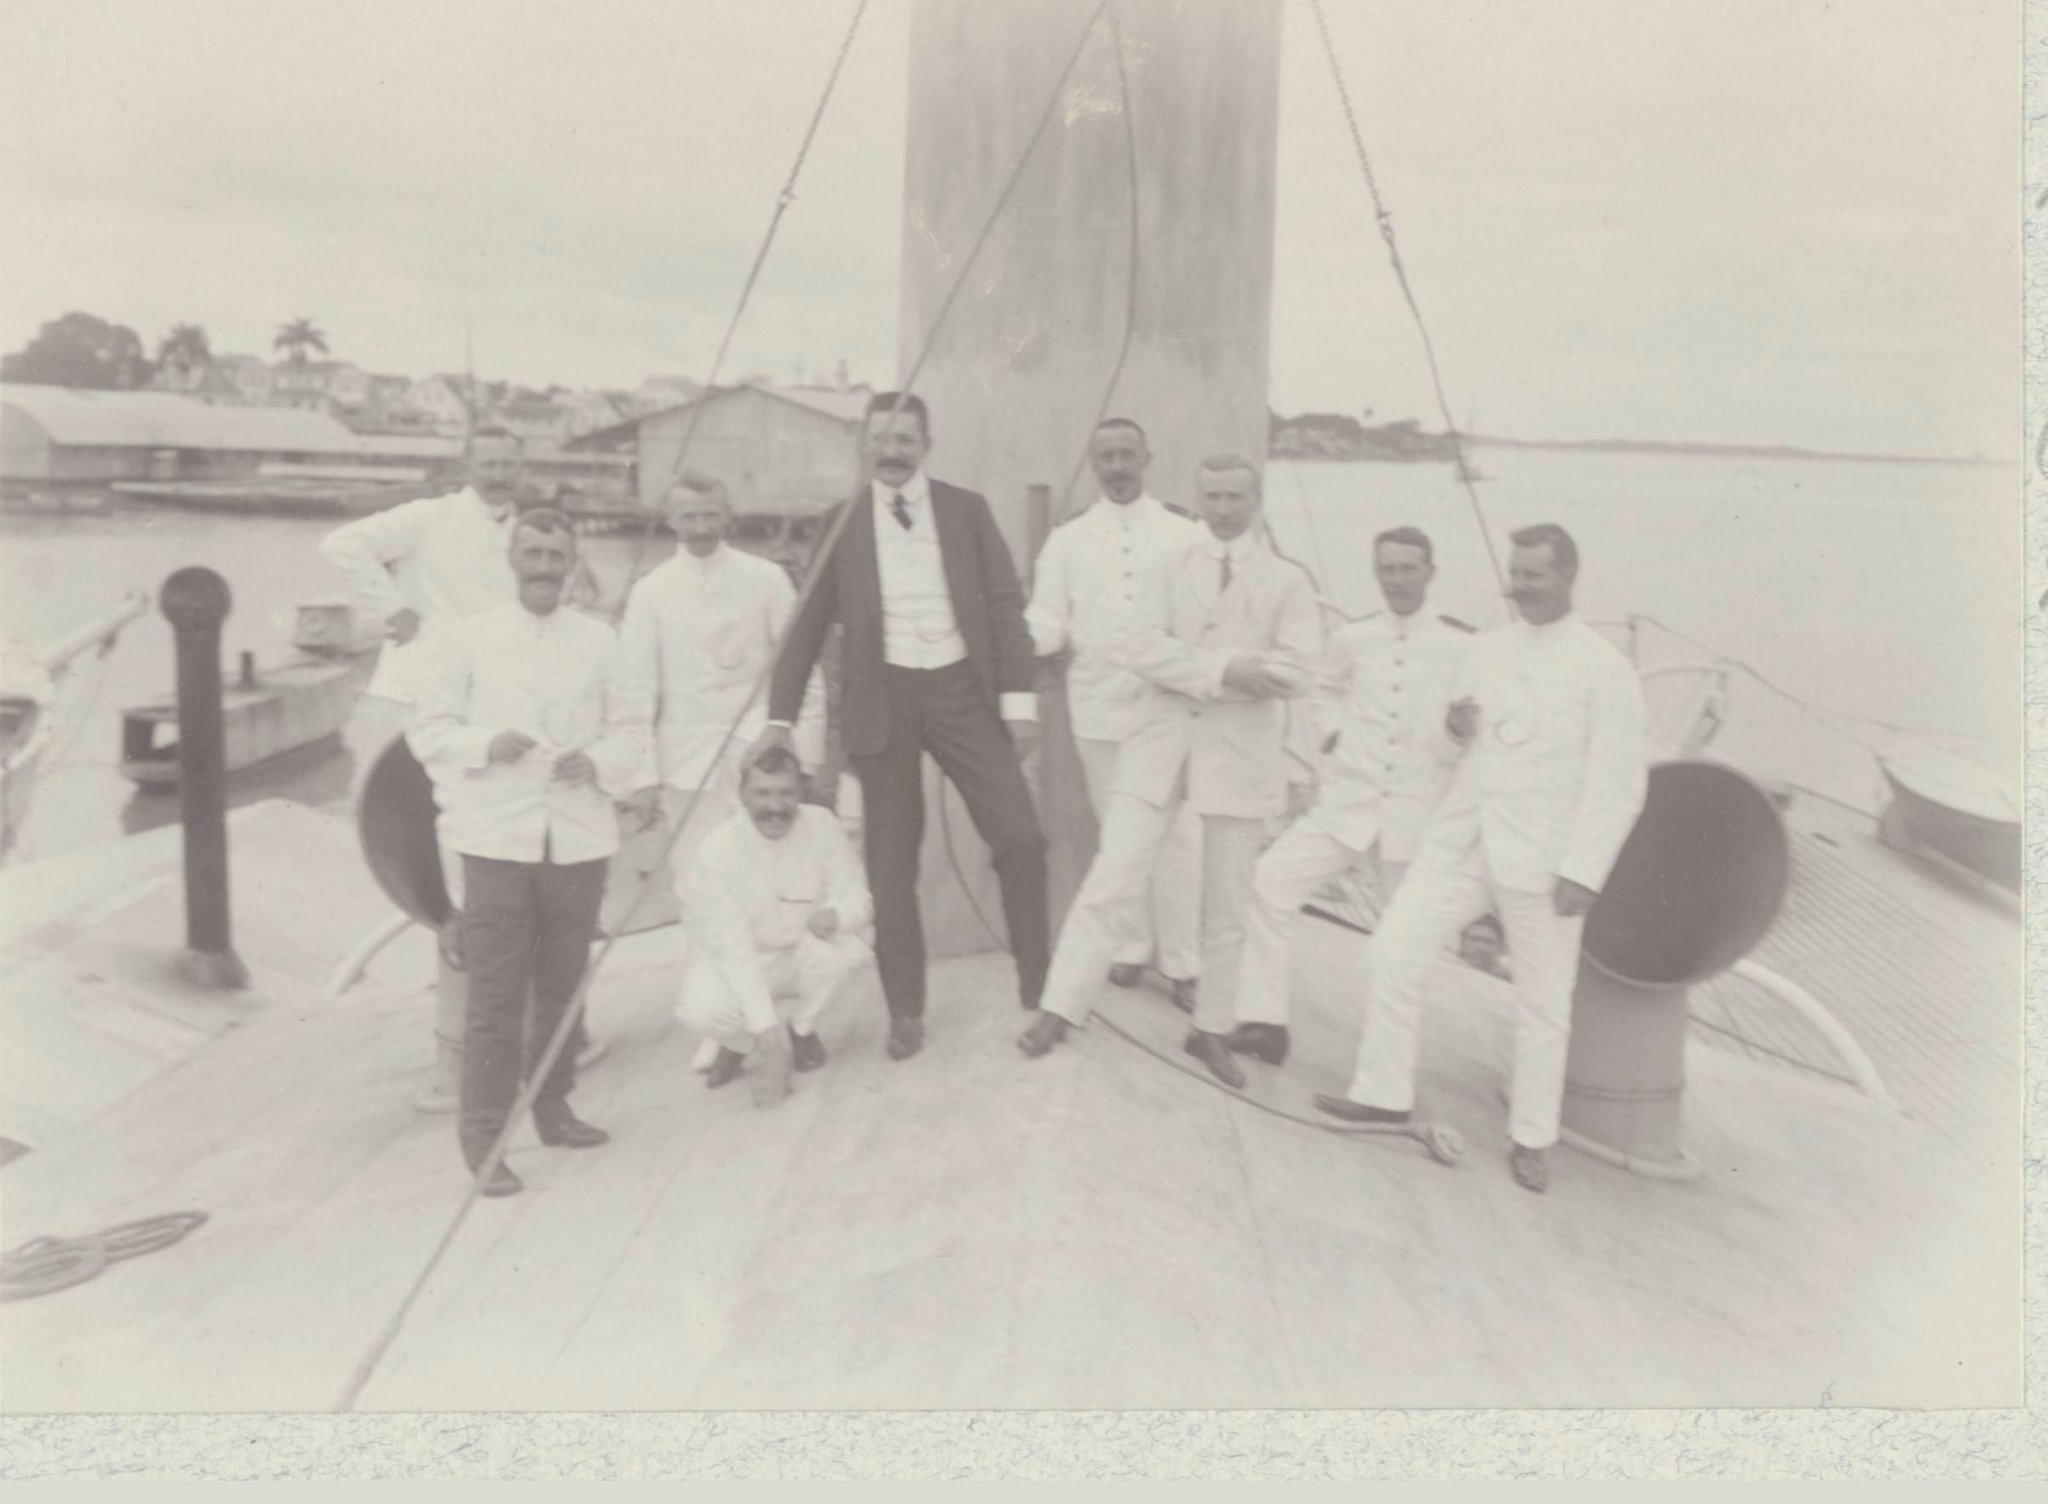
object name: photograph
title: Aan boord van de 'Koningin Wilhelmina'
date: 1904-1911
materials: photographic support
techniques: photography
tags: paramaribo (stad)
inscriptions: inscription: ‘kapt. Wijsmuller ... Na 't diner aan boord v/d Koningin Wilhelmina in een der Corantijn expeditie / P'bo April 1911’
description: Groepsfoto van de bemanning en gasten aan dek van het schip de 'Koningin Wilhelmina', Paramaribo, april 1911. Onderdeel van het fotoalbum van de familie Boom-Gonggrijp in Suriname en Curaçao.